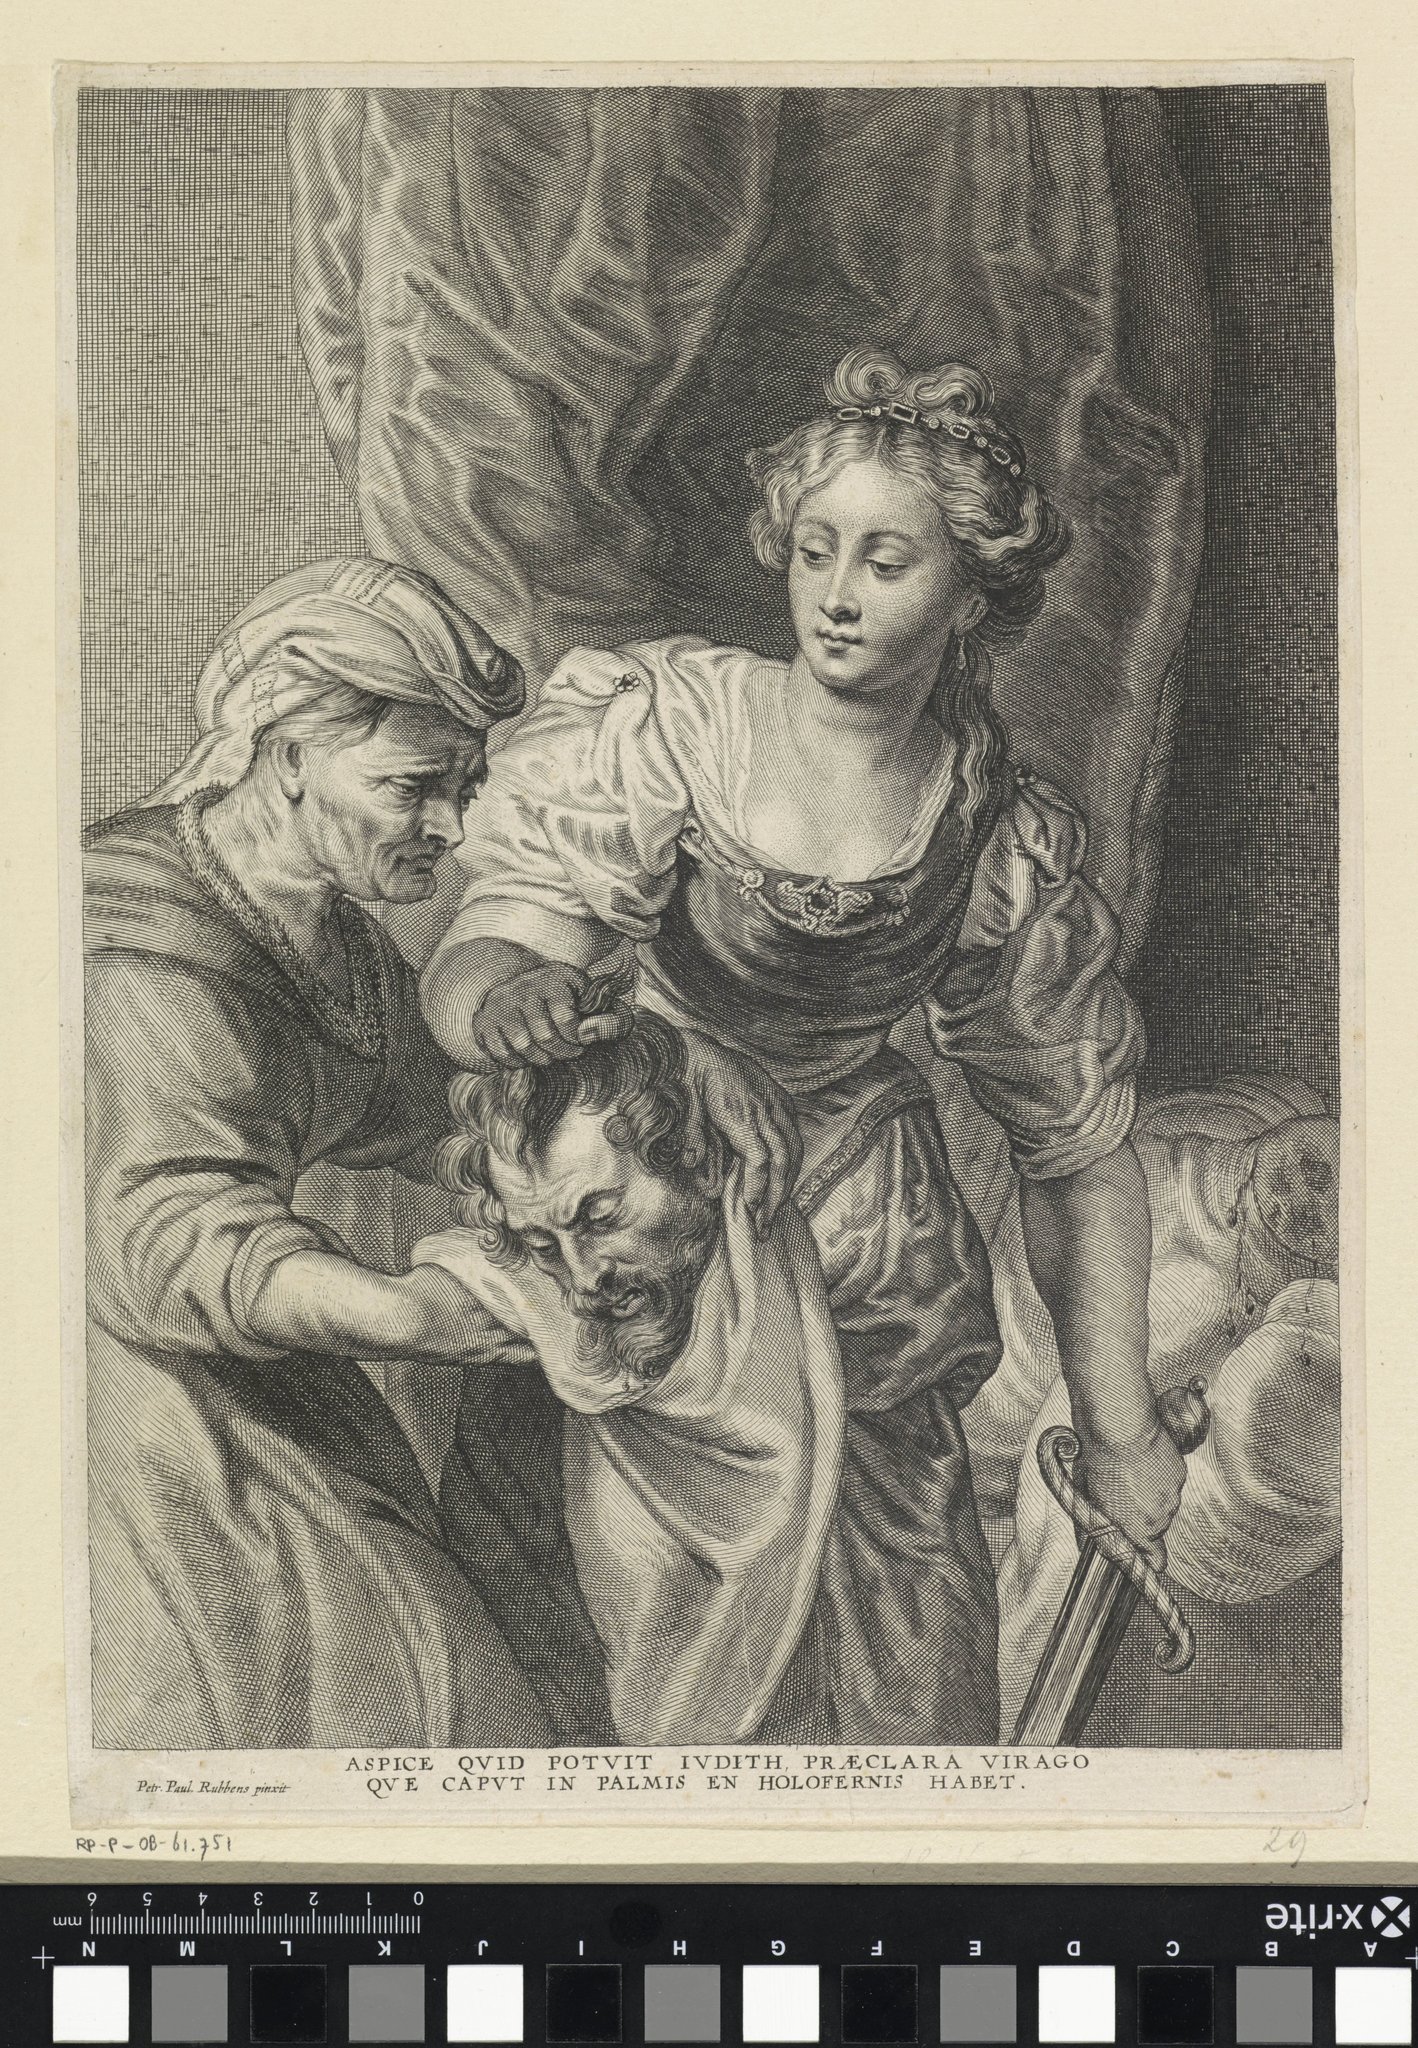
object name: print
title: Judit met het hoofd van Holofernes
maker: peter paul rubens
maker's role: draughtsman, painter, print maker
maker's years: 1577-1640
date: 1661-1695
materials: paper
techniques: engraving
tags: judith and her maidservant put holofernes' head in a sack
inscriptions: collector's mark: Lugt 240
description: Judit en haar dienstmaagd stoppen het hoofd van Holofernes in een zak. Verbeelding van het Bijvelverhaal Judit 8-16.